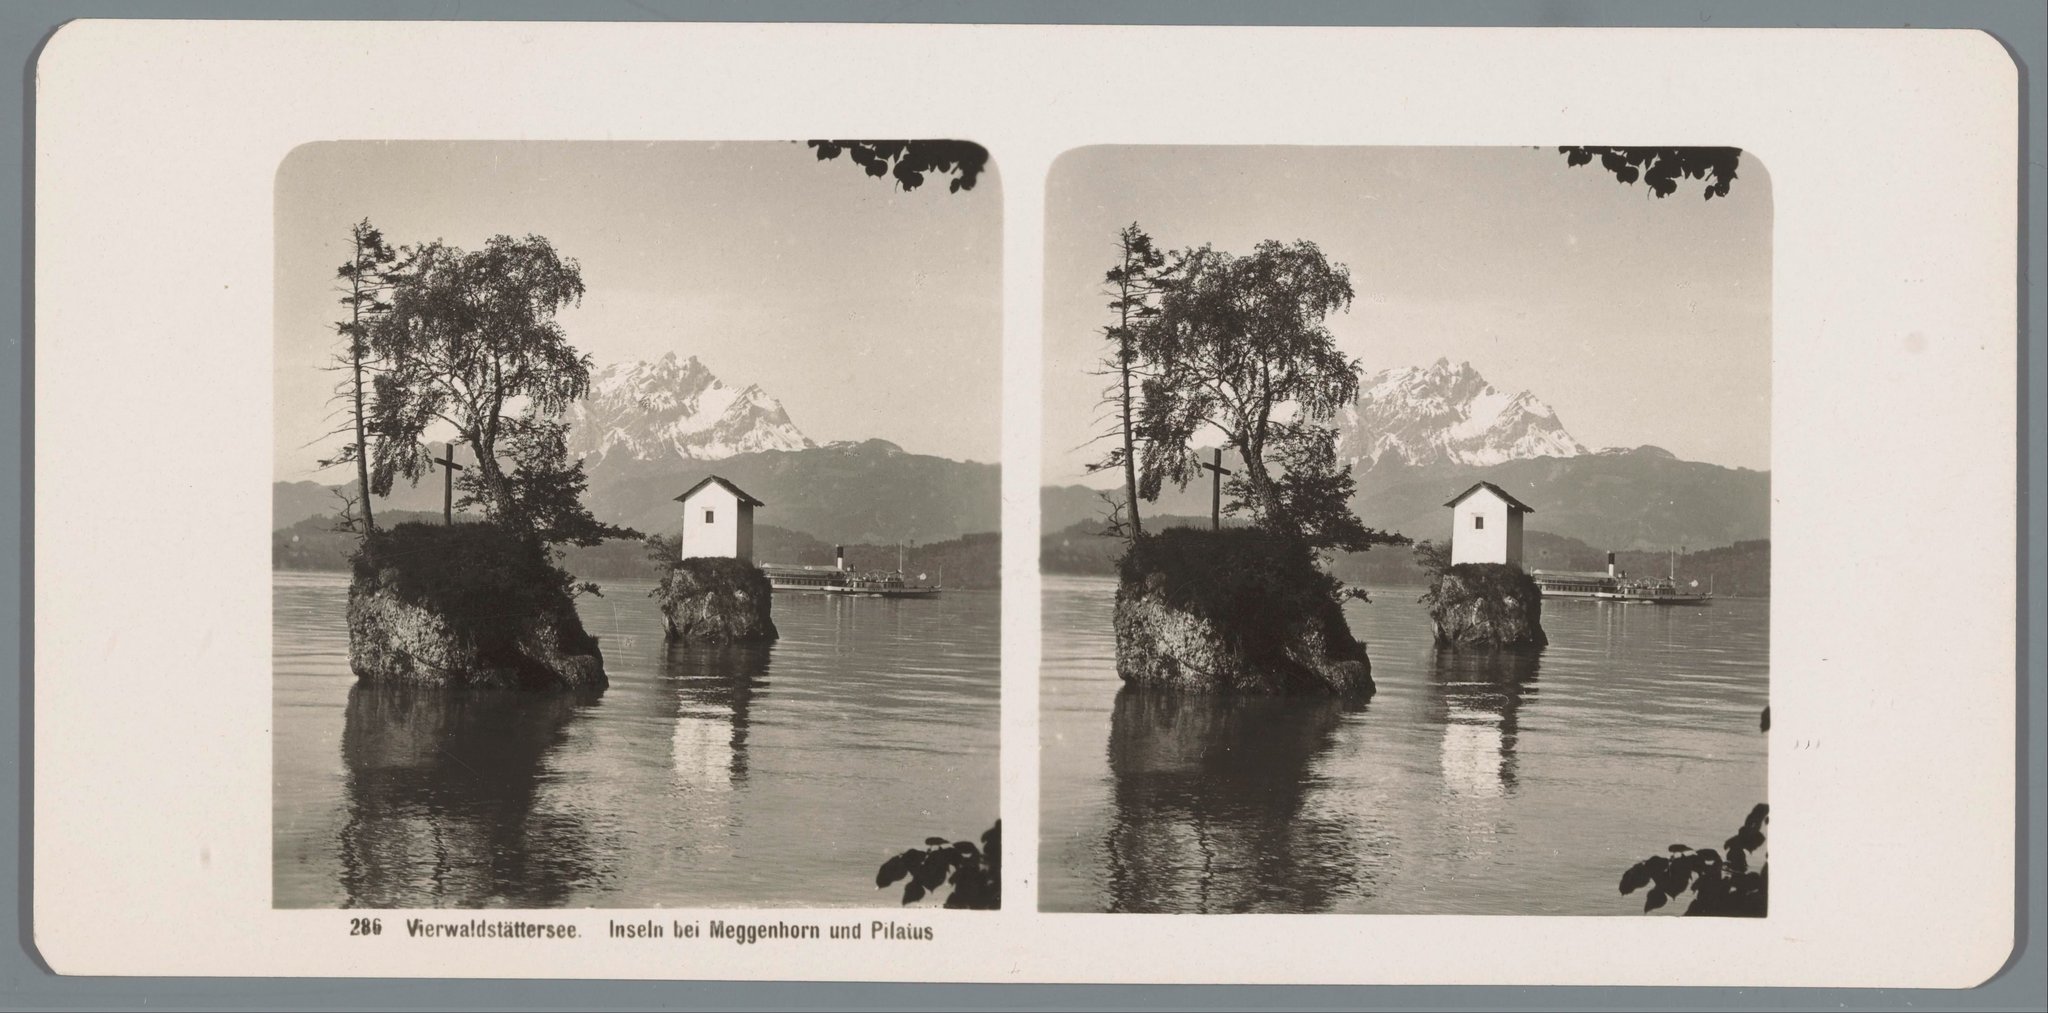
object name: stereograph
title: Eilanden in het Vierwoudstrekenmeer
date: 1900-1910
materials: cardboard, photographic support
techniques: gelatin silver print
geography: switzerland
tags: island, lake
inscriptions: number: ‘286’, inscription: ‘Wehrli A.-G. Kilchberg-Zürich’